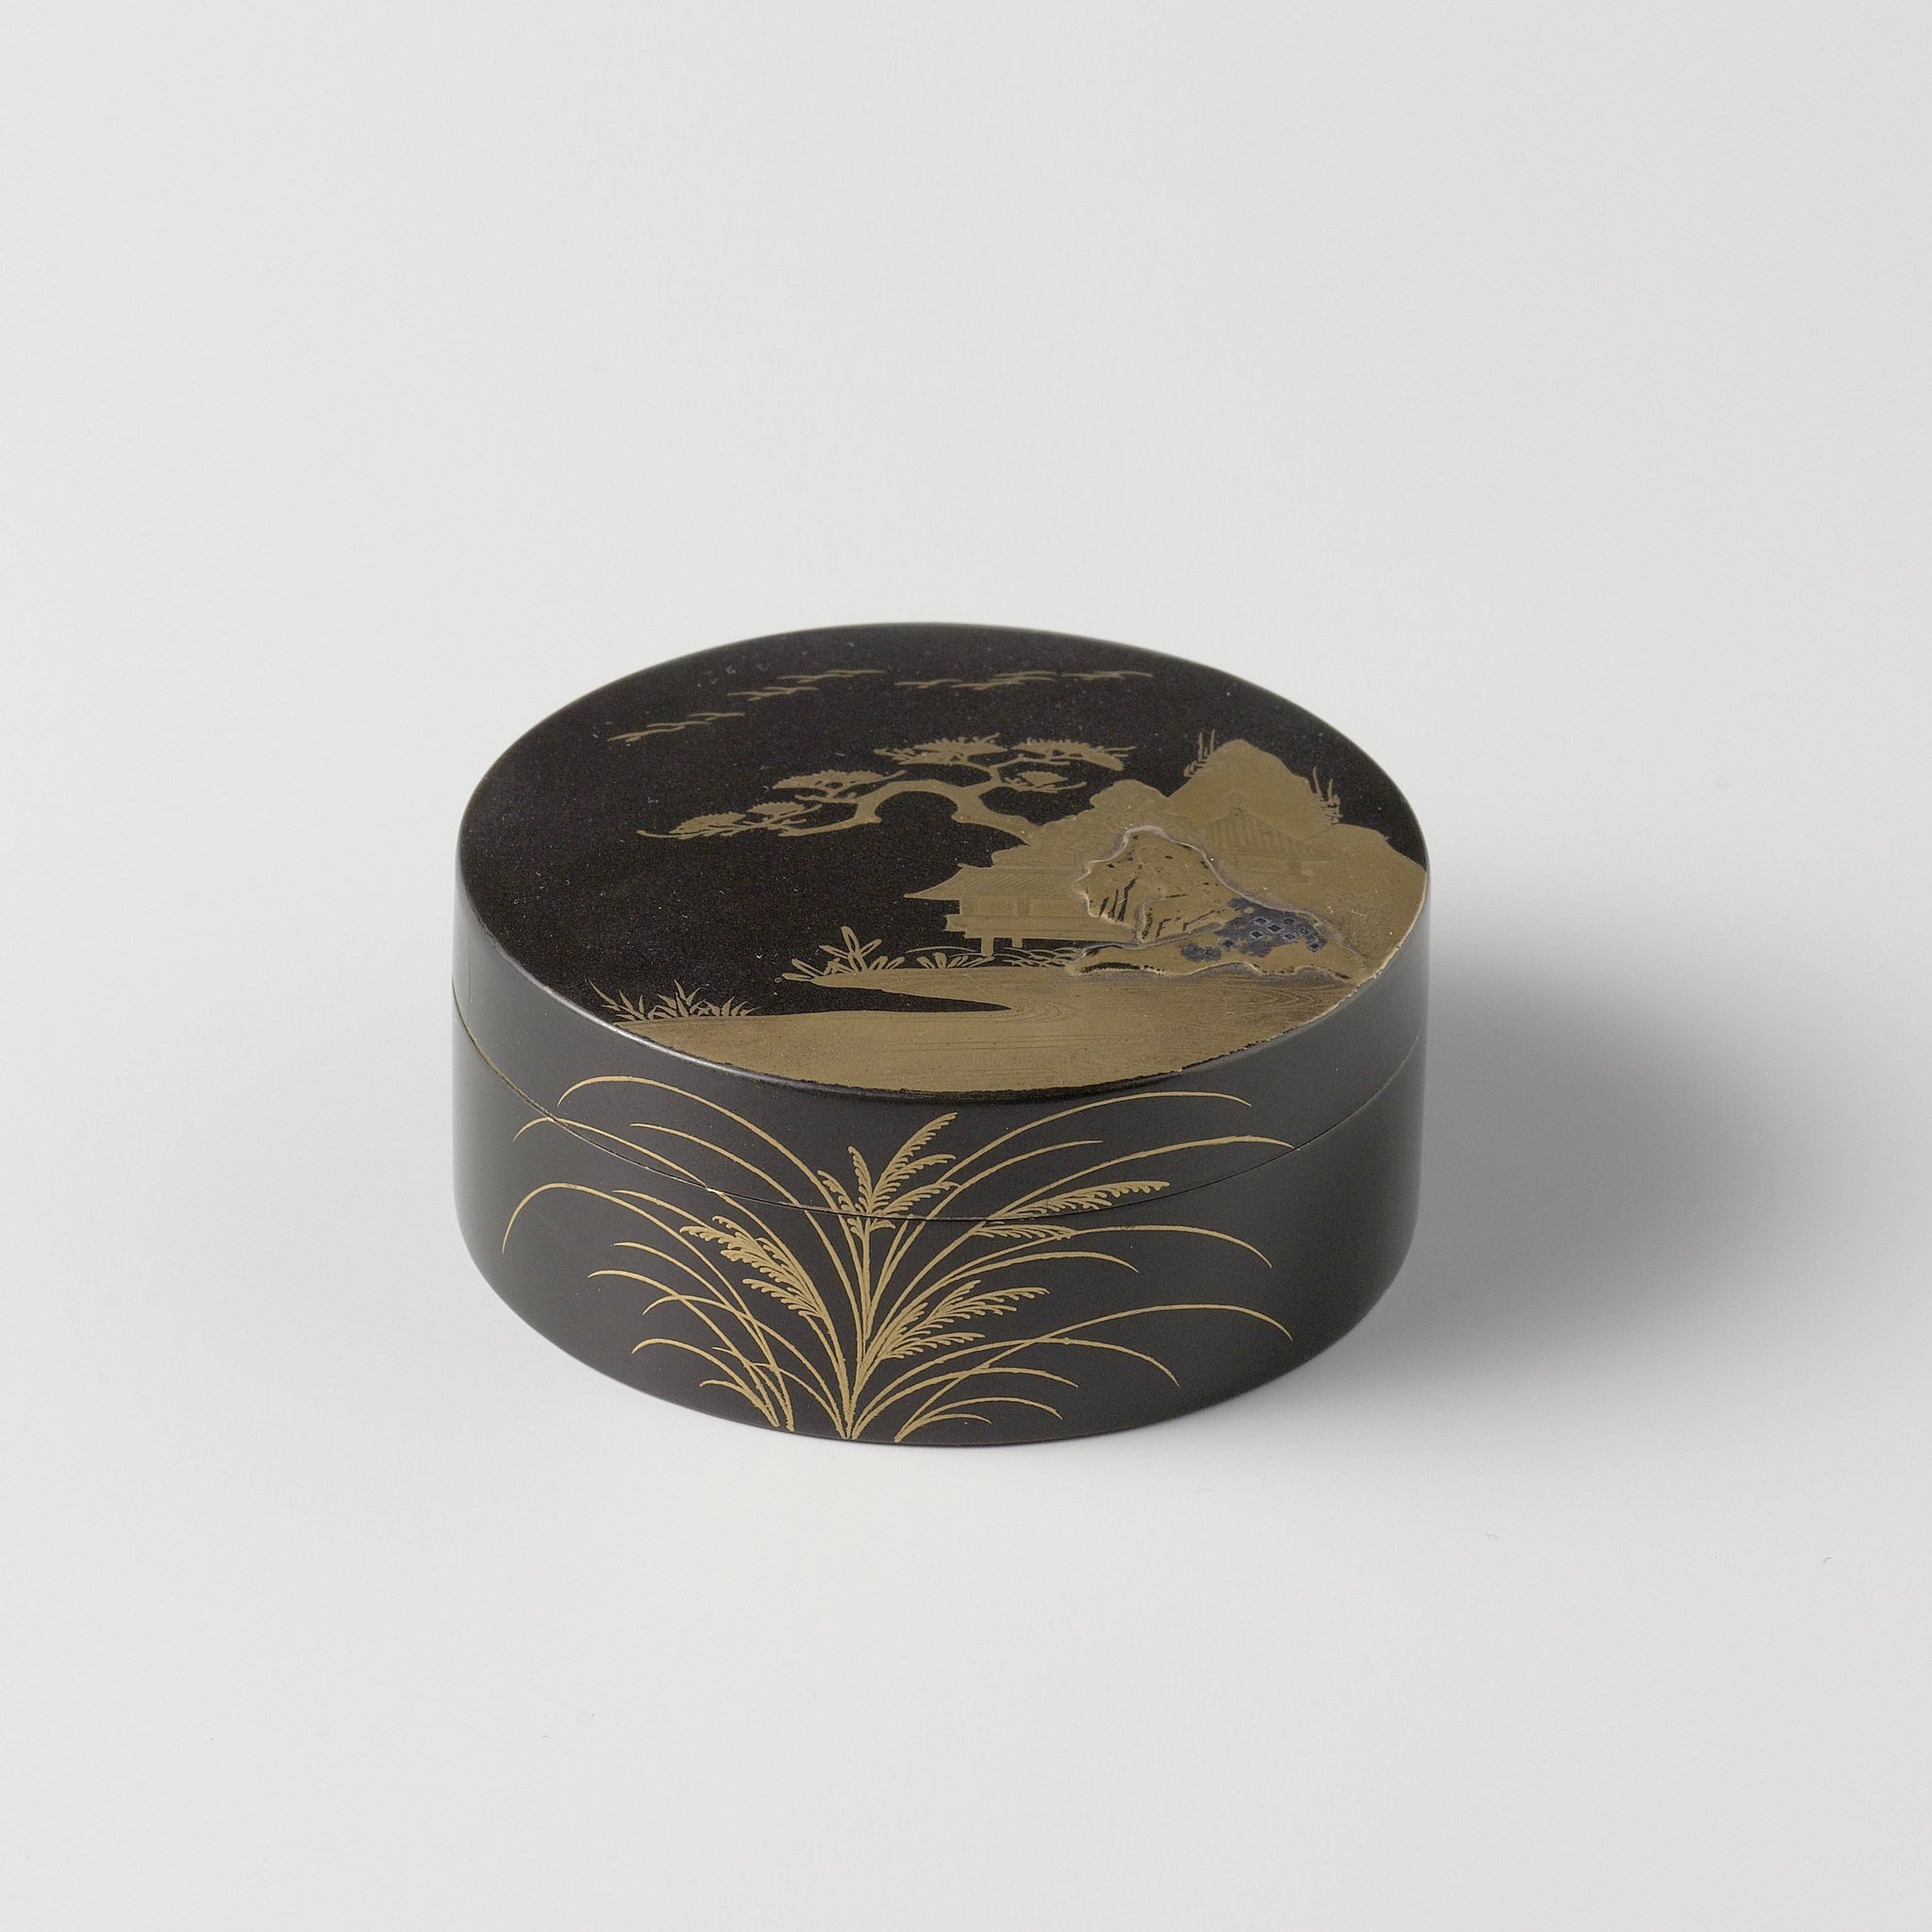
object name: box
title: Doos, zwarte lak met waterlandschap in goud makie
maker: Anonymous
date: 1700-1800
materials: gold, lacquer, wood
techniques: lacquer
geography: japan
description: Ronde doos met een enigszins bolle deksel. Dedekt met zwarte lak waarop landschappen en grassen in goud makie en metalen stippen; van binnen nishiji.